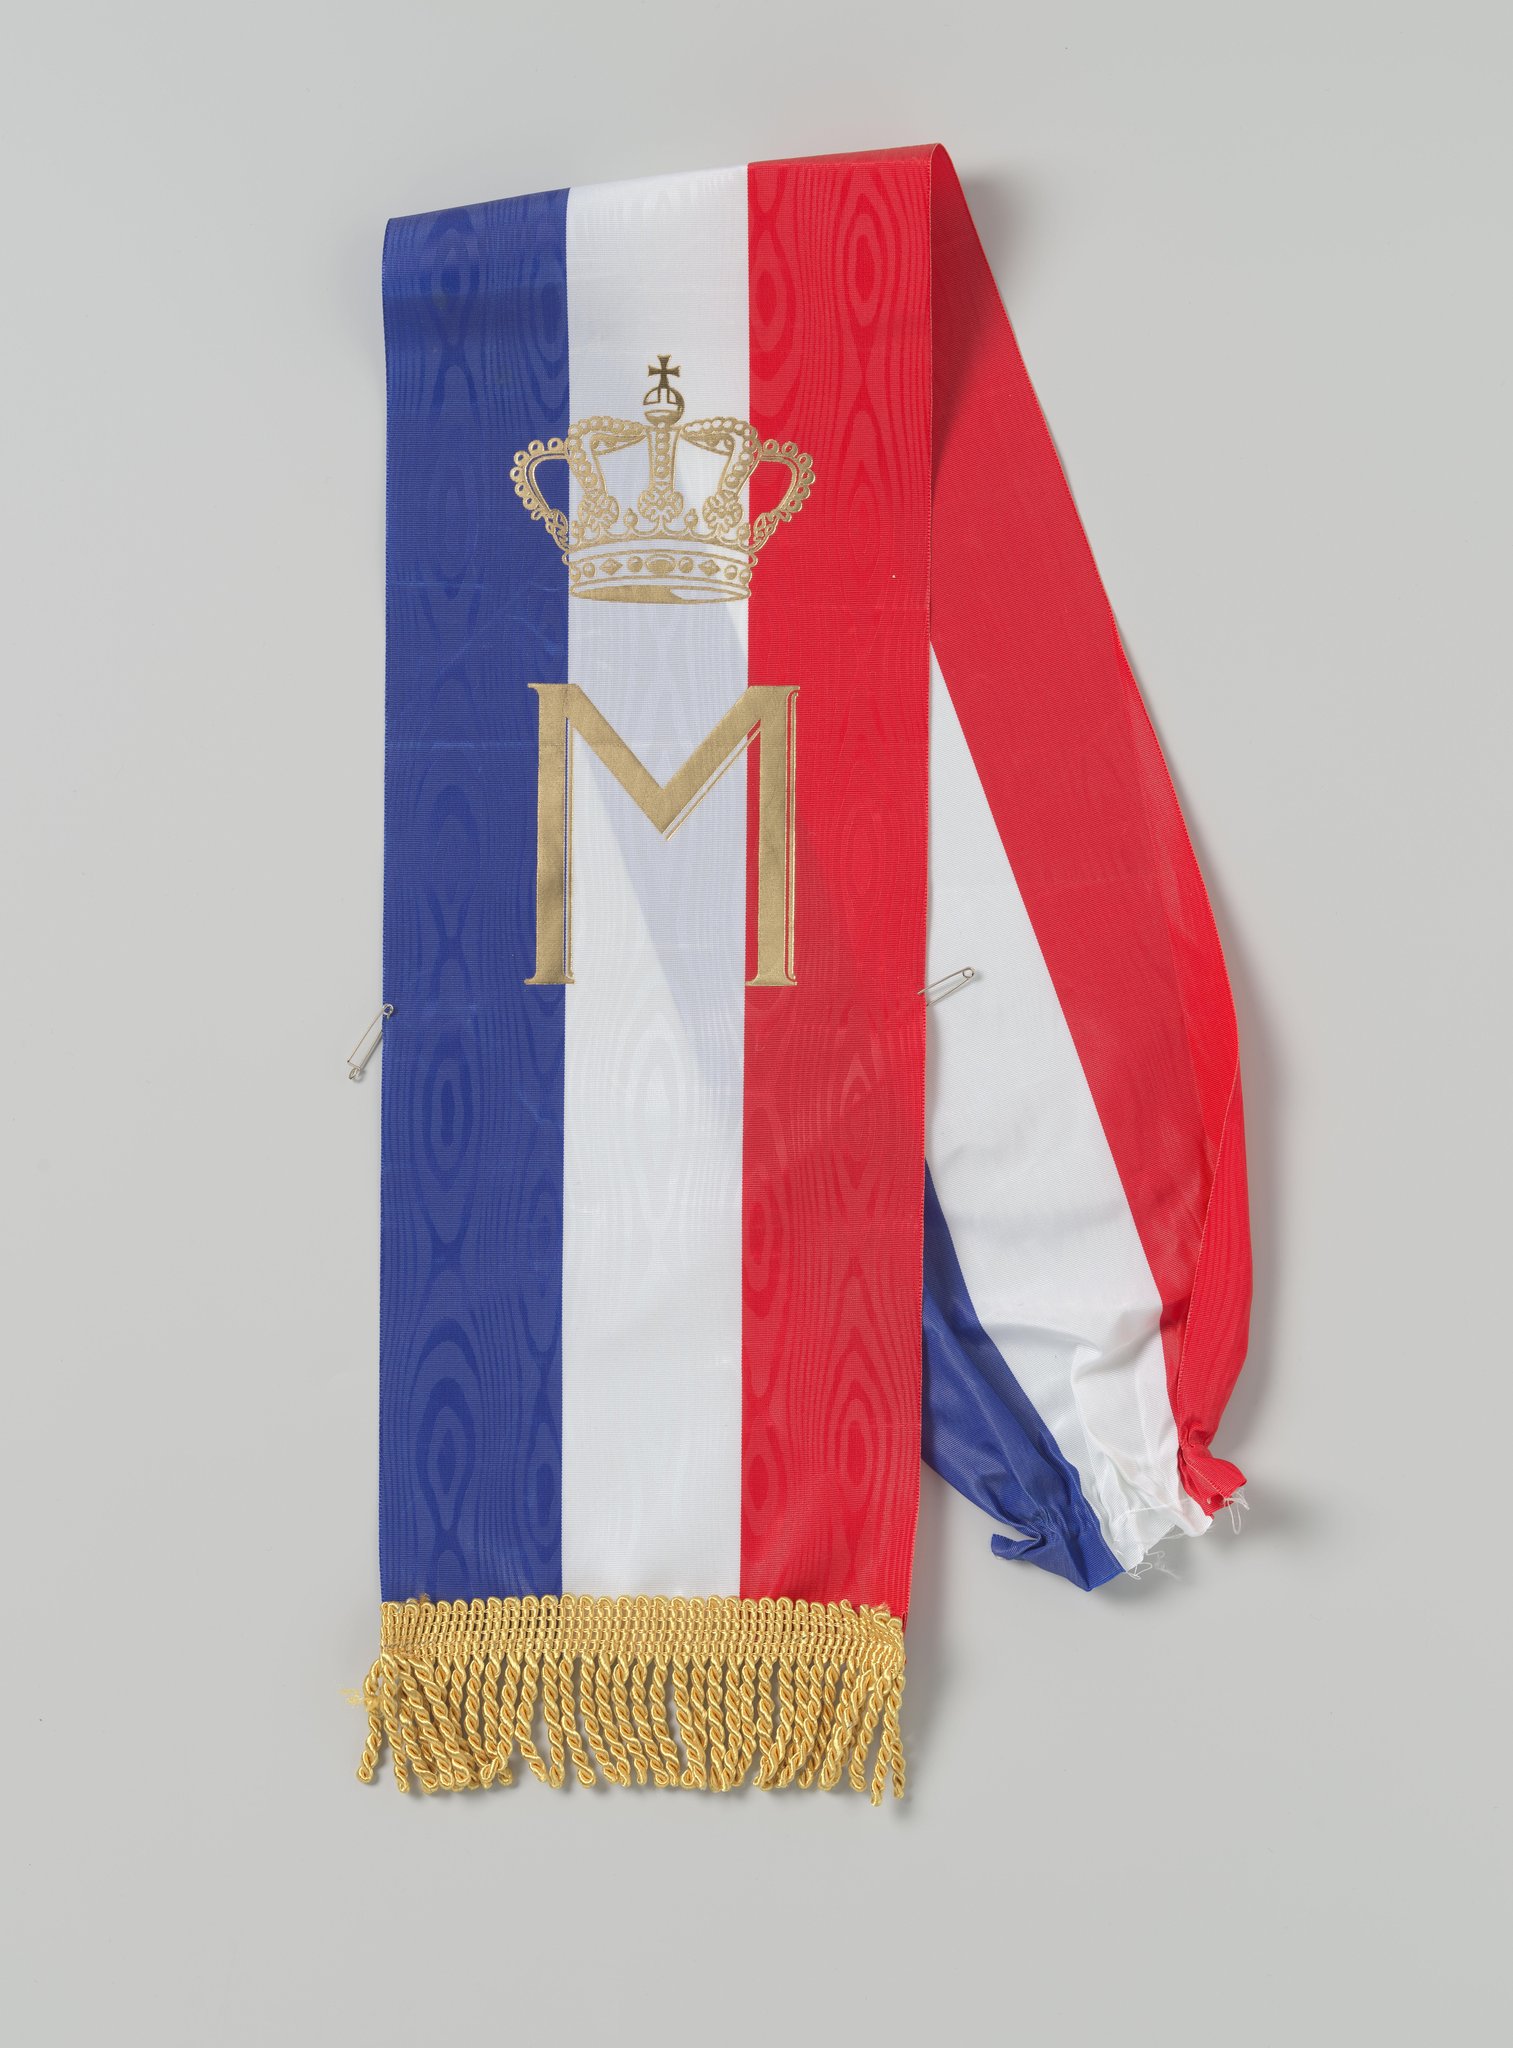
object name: ribbon material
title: Koninklijk lint met initiaal M van Máxima (koningin der Nederlanden)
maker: Anonymous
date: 2023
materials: textile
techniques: printing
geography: netherlands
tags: buenos aires, máxima (koningin der nederlanden), oosterpark, keti-koti, excuses nederlandse koning voor slavernijverleden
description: Koninklijk lint met initiaal M van Máxima (koningin der Nederlanden). In het rood, wit, blauw van de Nederlandse vlag, met gouden franje aan het uiteinde.